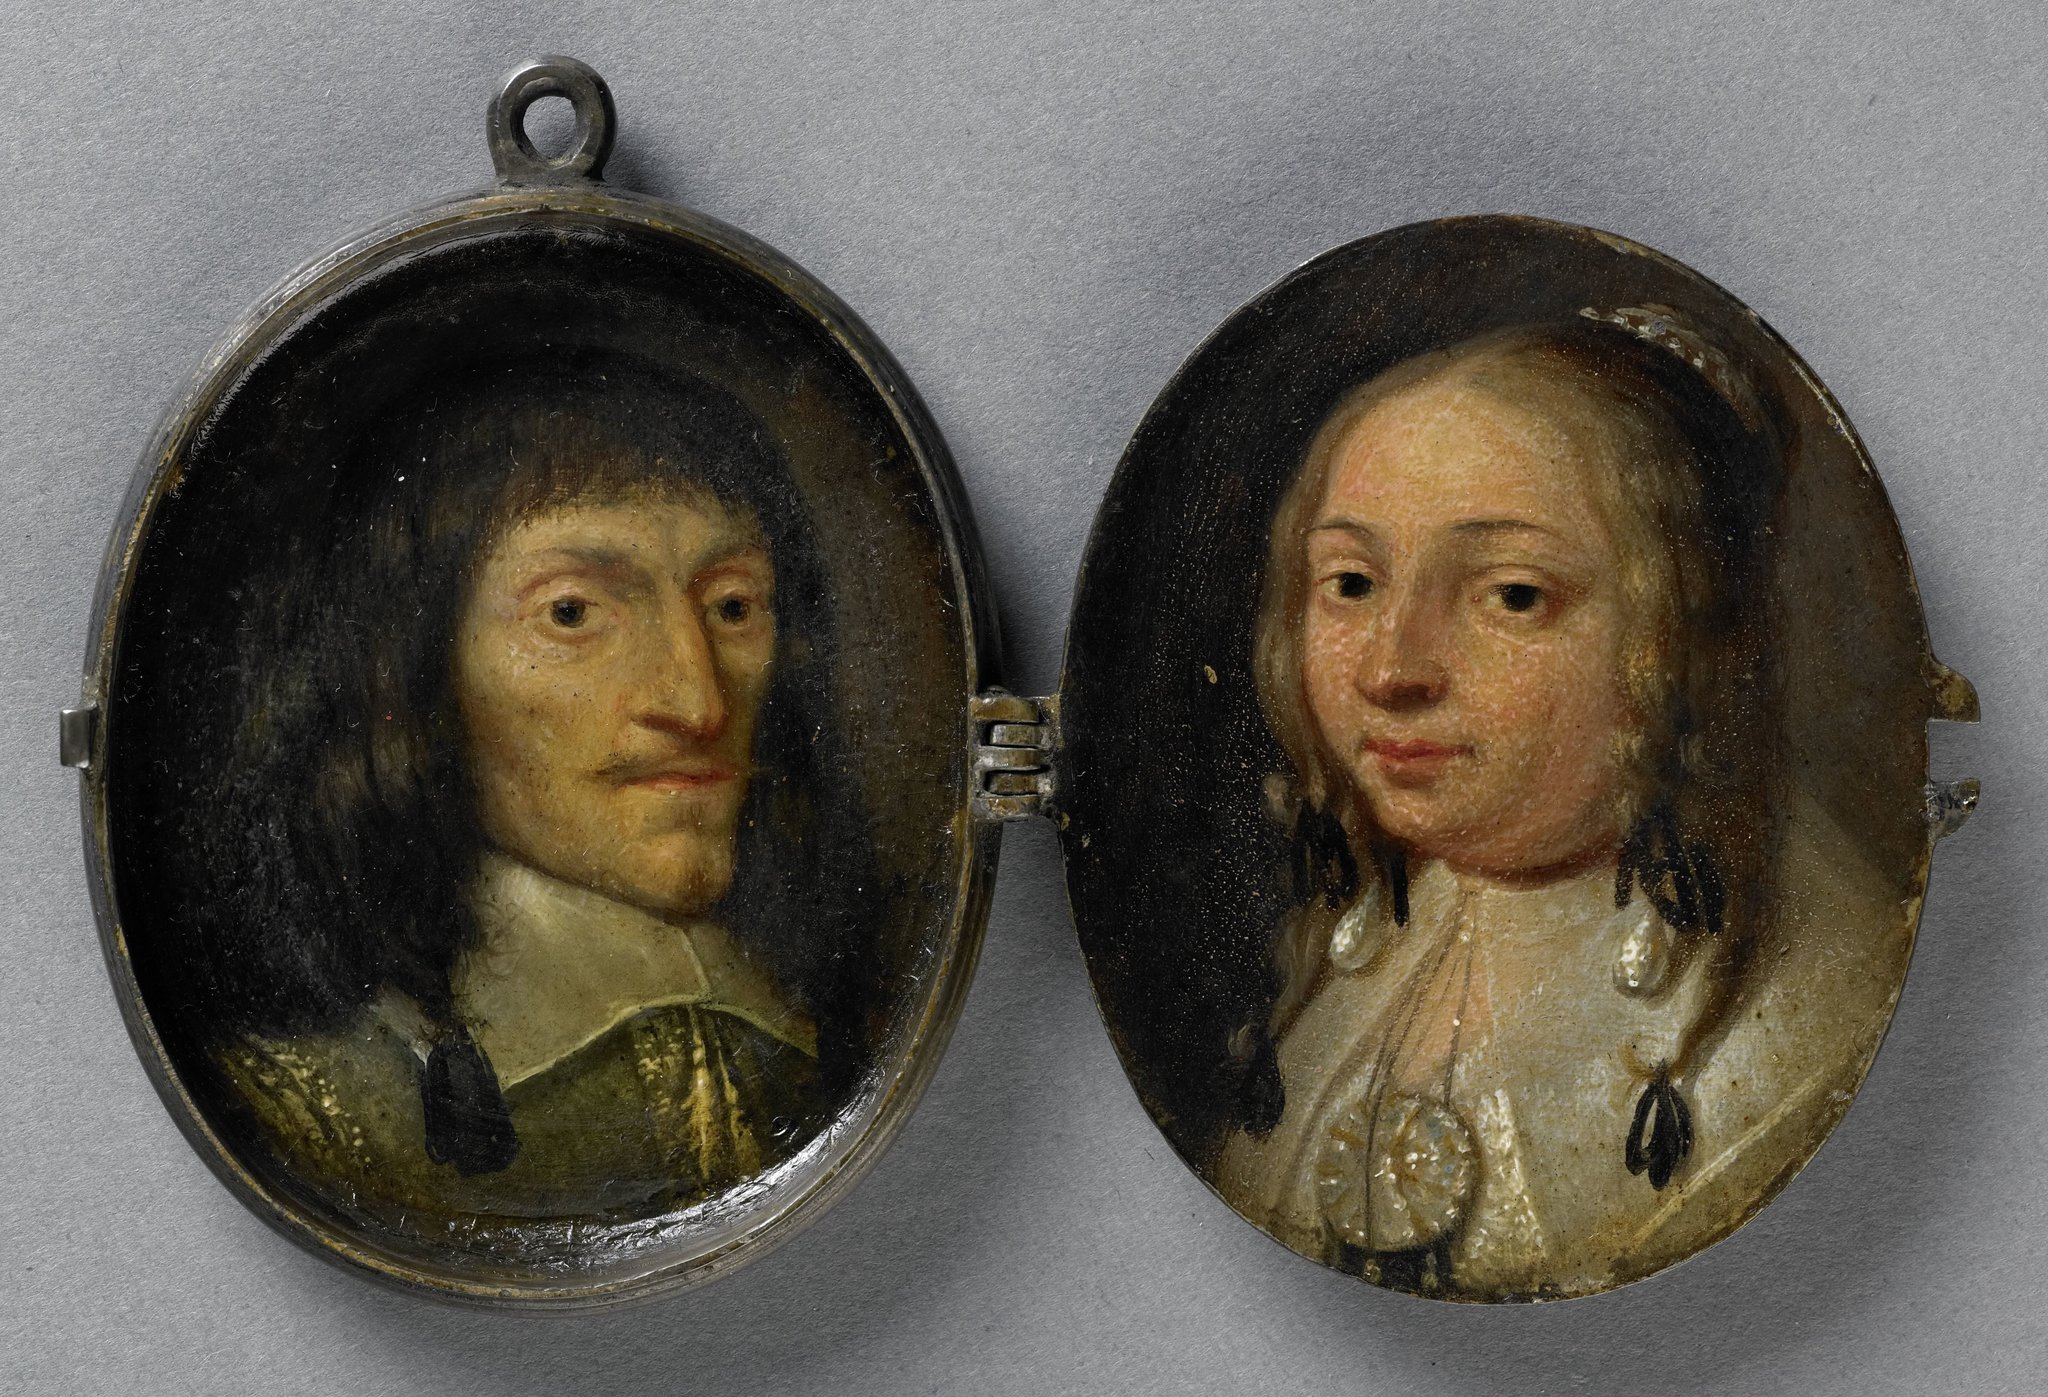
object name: locket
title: Portret van een man en een vrouw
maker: Anonymous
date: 1645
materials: oil, silver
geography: northern netherlands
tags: historical persons not known by name - bb - woman, historical persons not known by name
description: Portret van een man en een vrouw. Buste, de man naar rechts, de vrouw naar links. Geschilderd op de bodem en de binnenzijde van de deksel van een medaillon. Onderdeel van de collectie portretminiaturen.